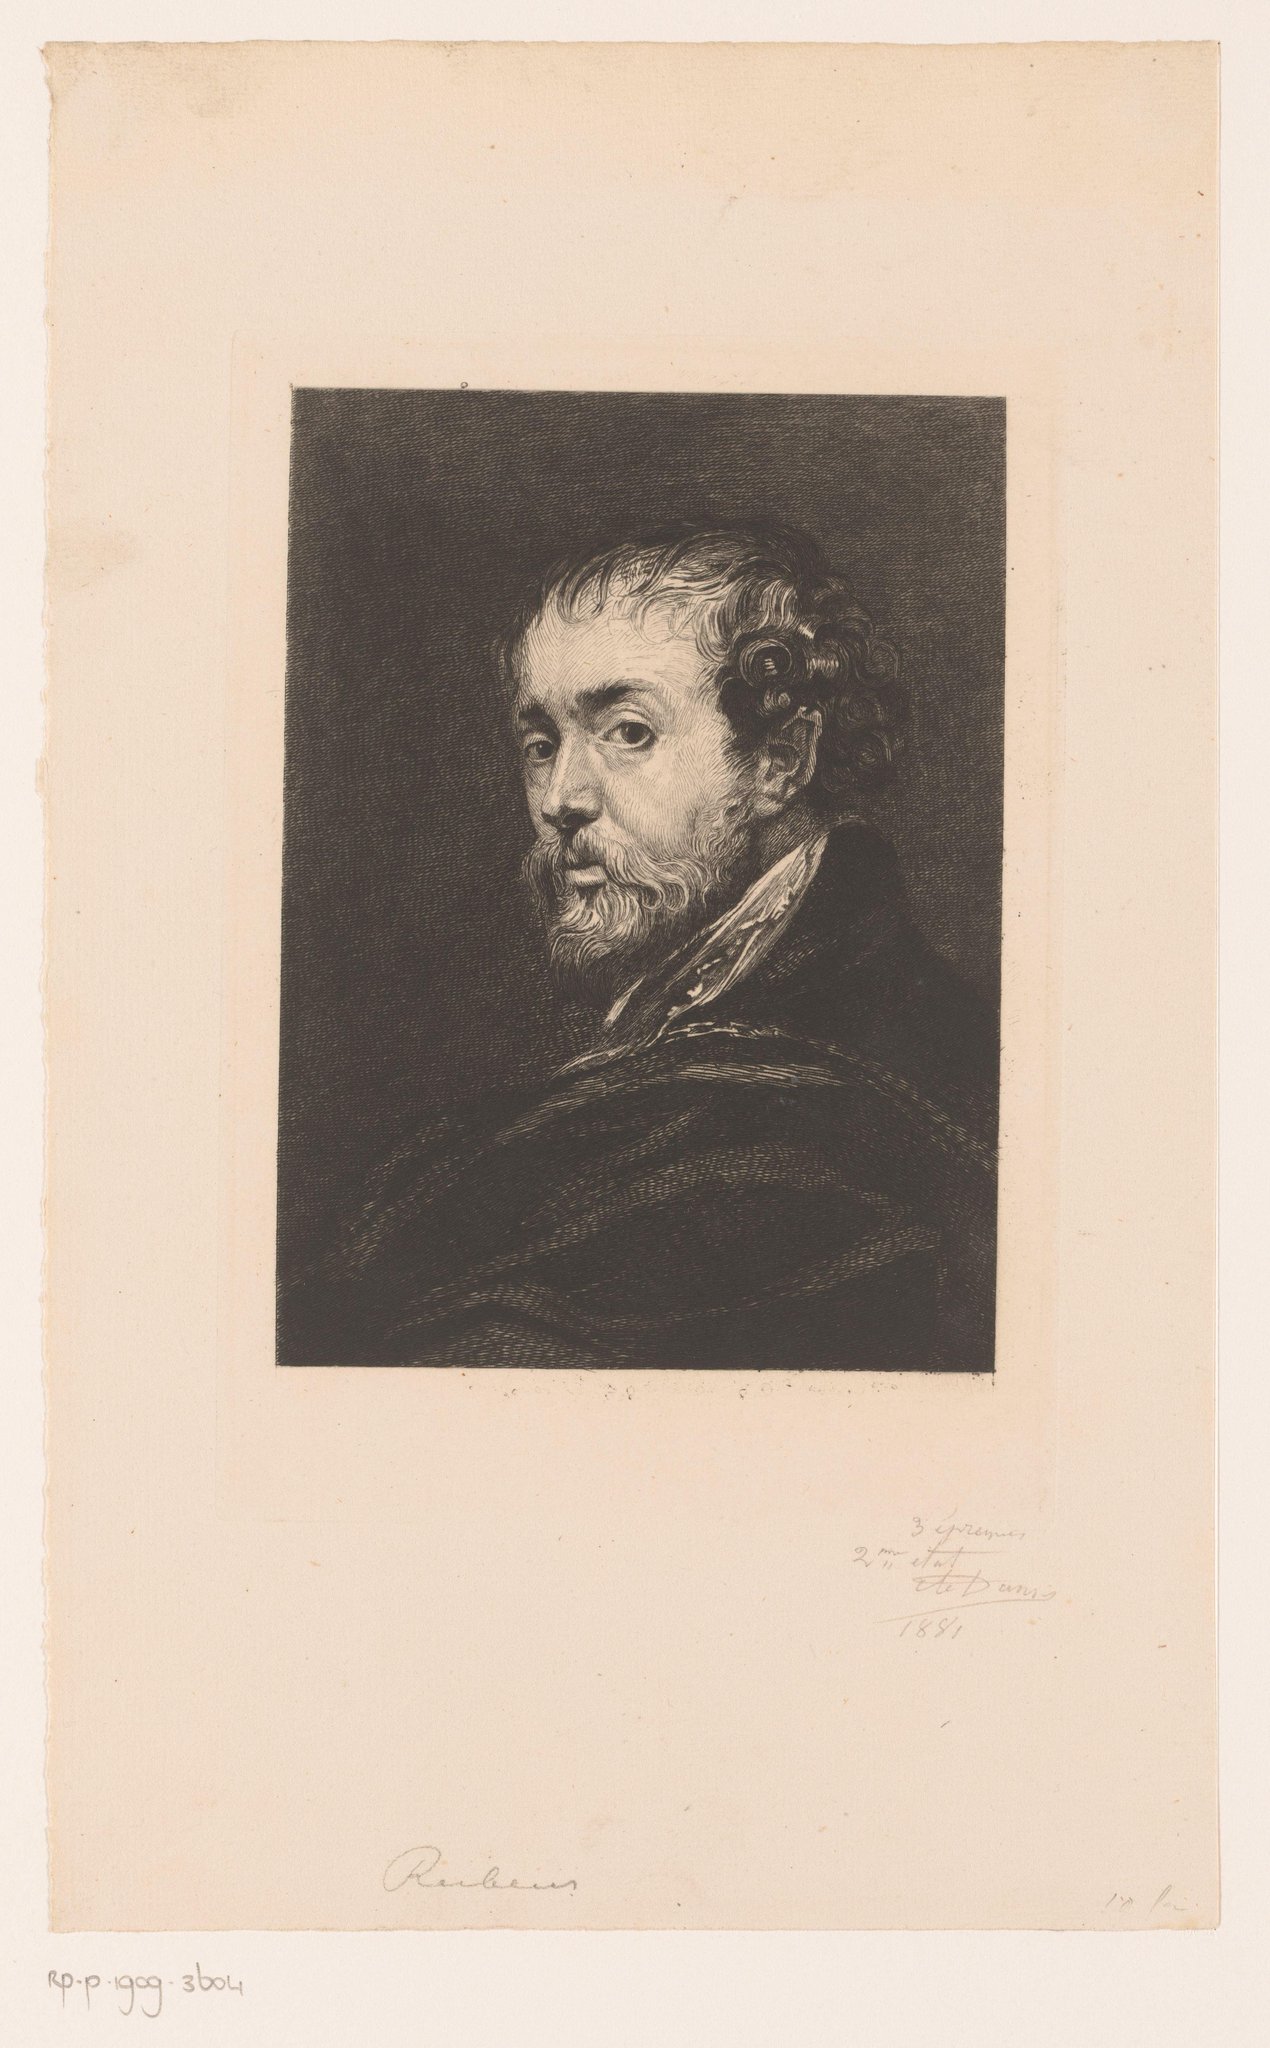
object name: print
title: Portret van Félix Nève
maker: auguste danse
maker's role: print maker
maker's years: 1829-1929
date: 1893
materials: paper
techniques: etching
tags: historical person (...) - historical person (...) portrayed alone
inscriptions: annotation: ‘3m état’, collector's mark: Lugt 2228